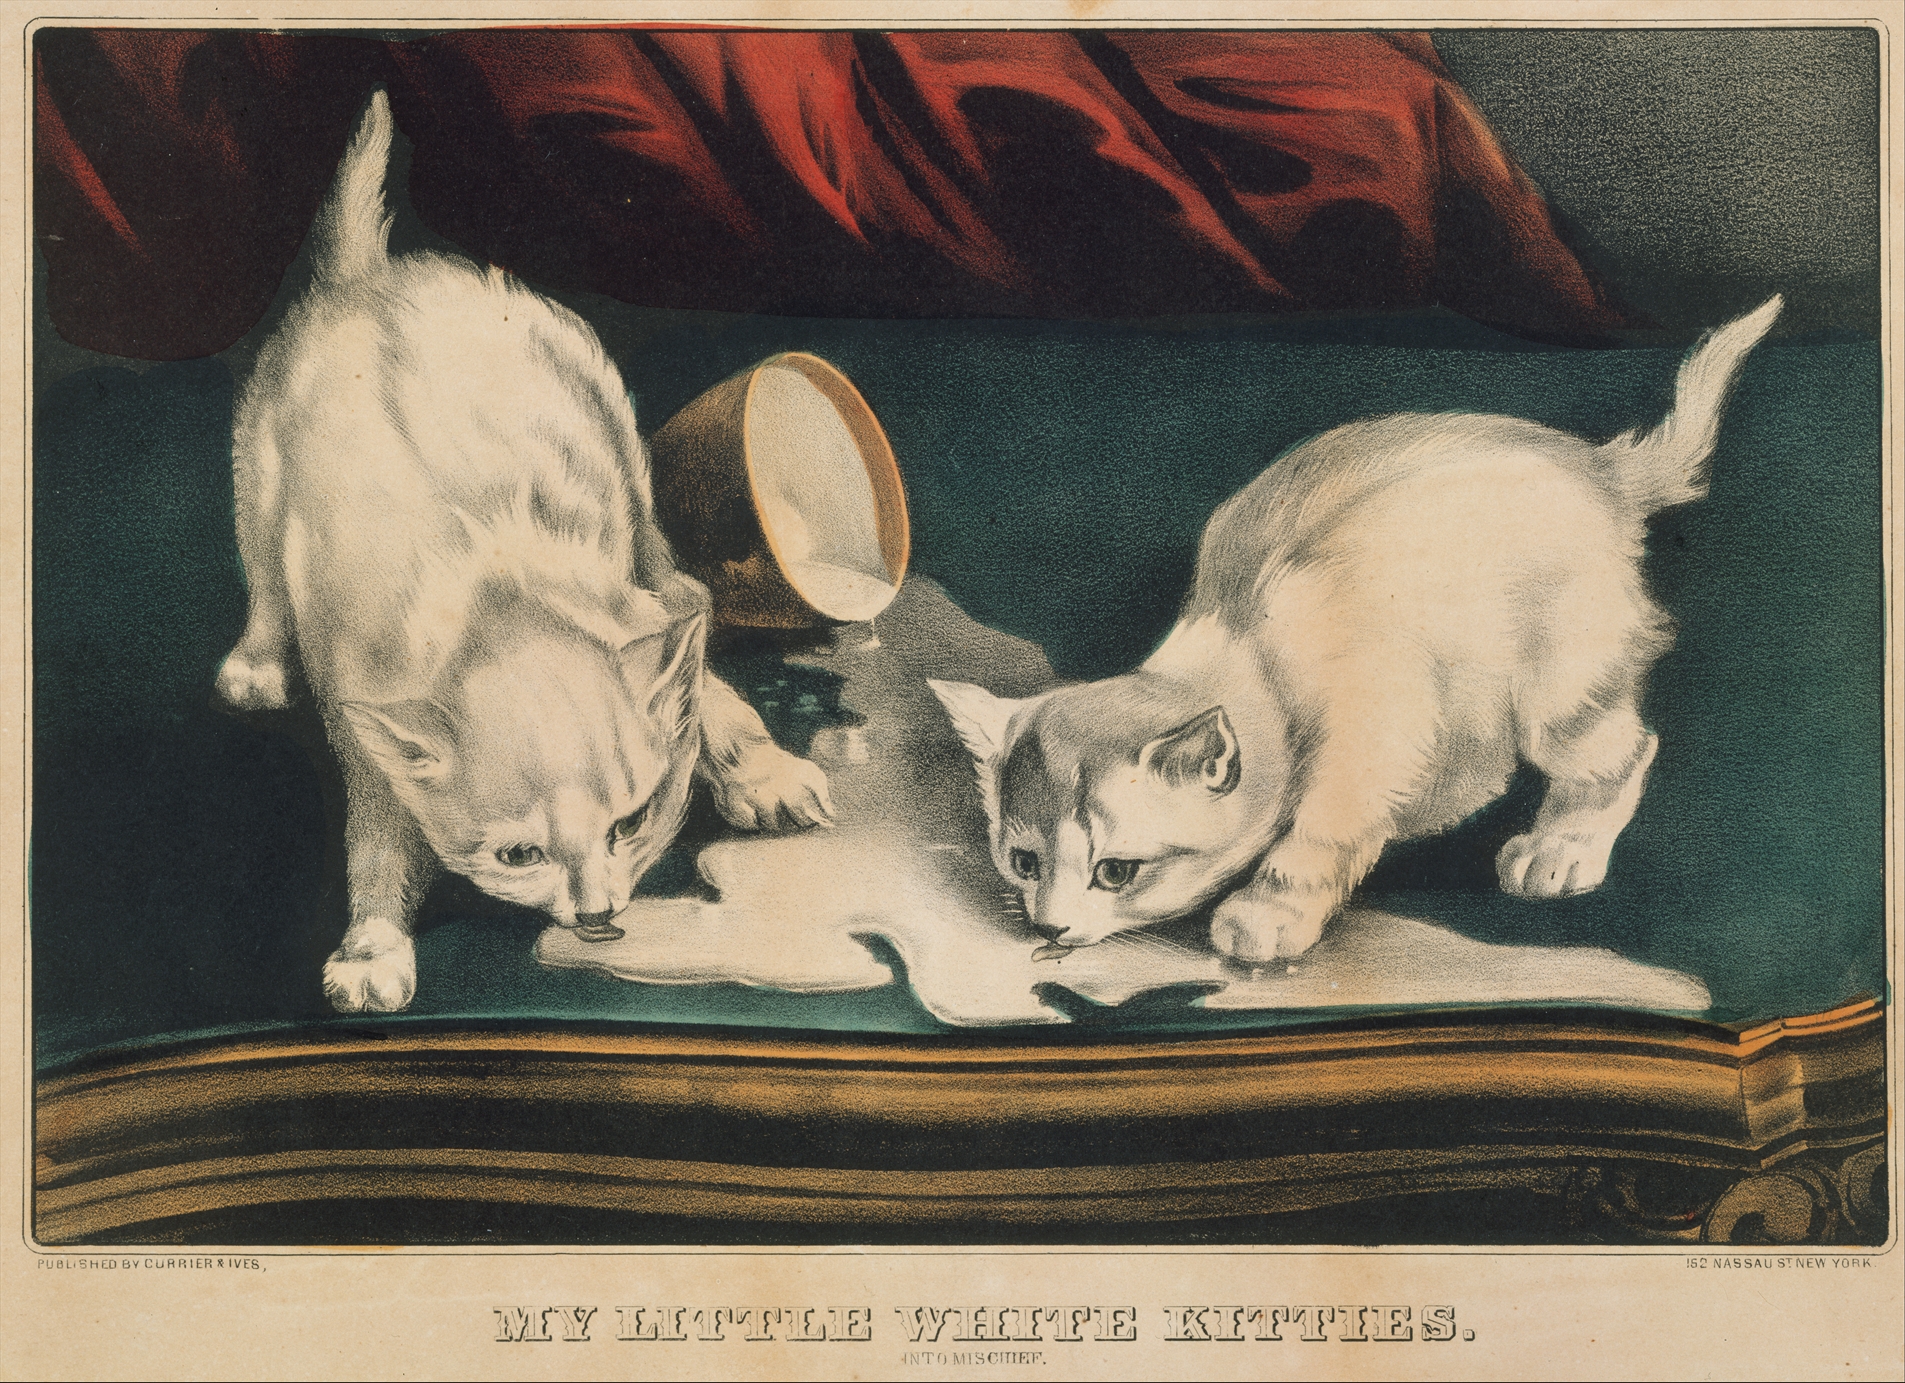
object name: print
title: My Little White Kitties – Into Mischief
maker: currier & ives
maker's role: publisher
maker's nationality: american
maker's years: 1857-1907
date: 1857-1871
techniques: hand coloring, lithograph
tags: cats